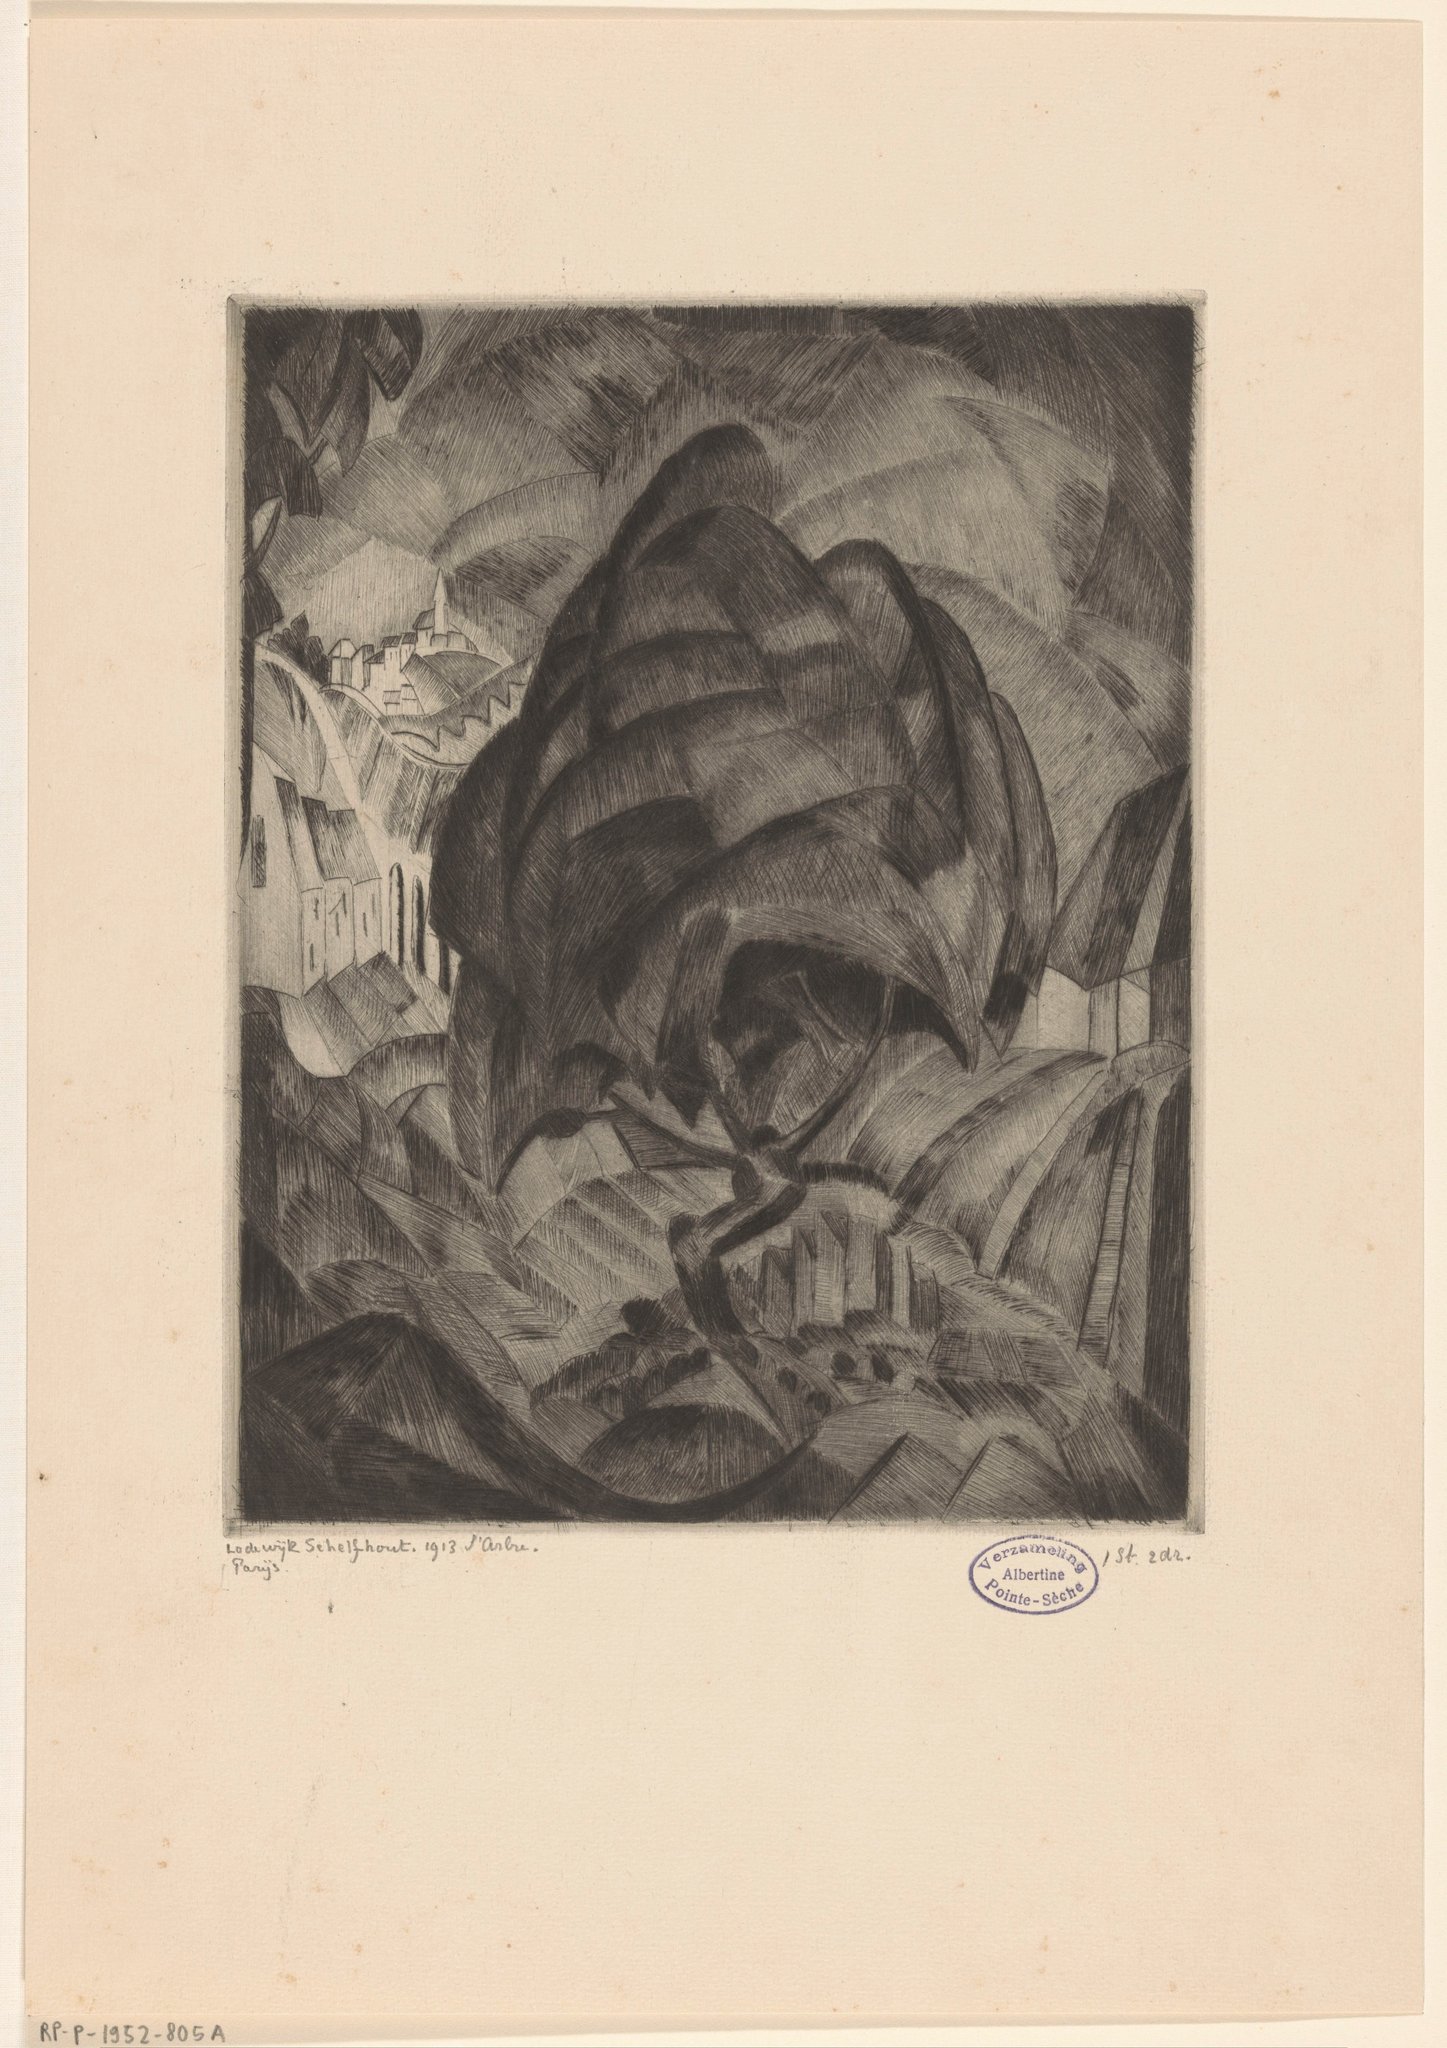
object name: print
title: Boom in een heuvellandschap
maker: lodewijk schelfhout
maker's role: draughtsman, print maker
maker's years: 1881-1943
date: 1913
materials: paper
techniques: drypoint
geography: paris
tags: prospect of village, silhouette of village, low hill country, trees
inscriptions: collector's mark: Lugt 2760, collector's mark: Lugt 2228, collector's mark: Lugt 5i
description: Links op de achtergrond een nederzetting met kerk.